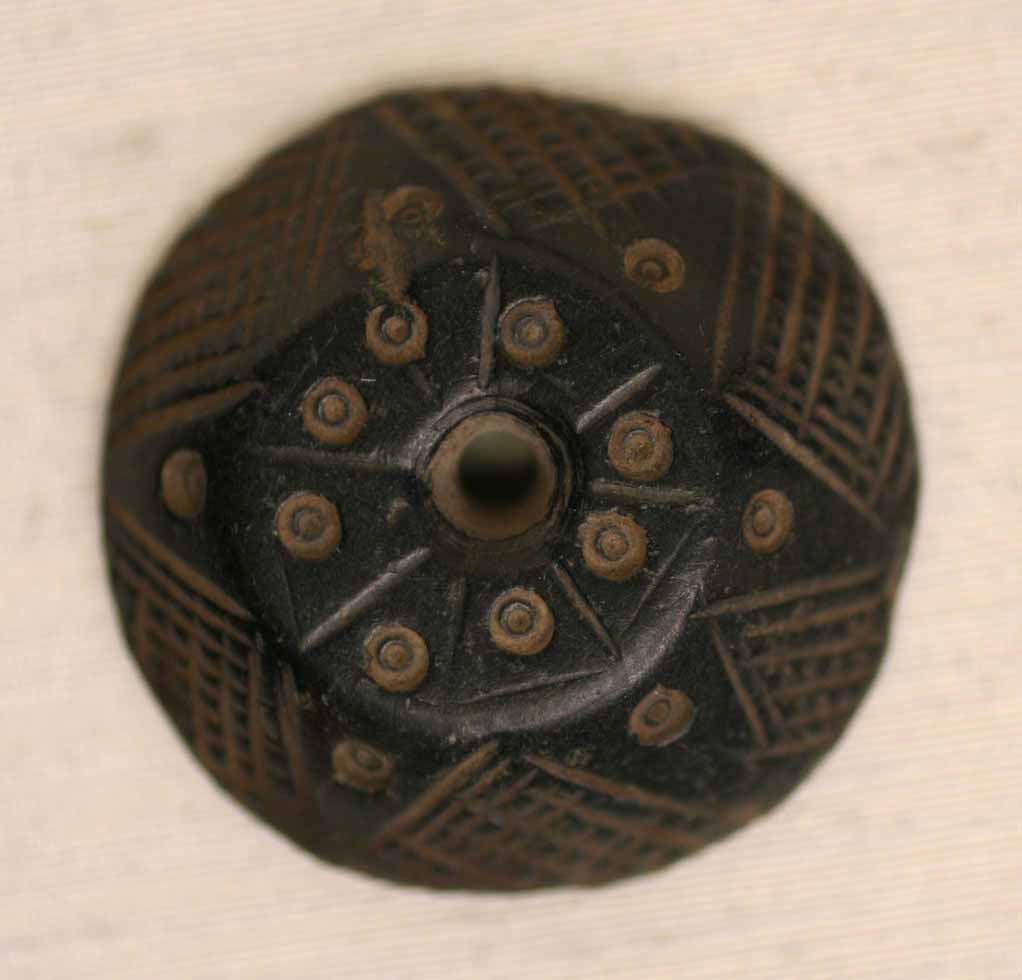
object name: spindle whorl or gaming piece or ornament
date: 701-1000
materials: stone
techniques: incising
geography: egypt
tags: games